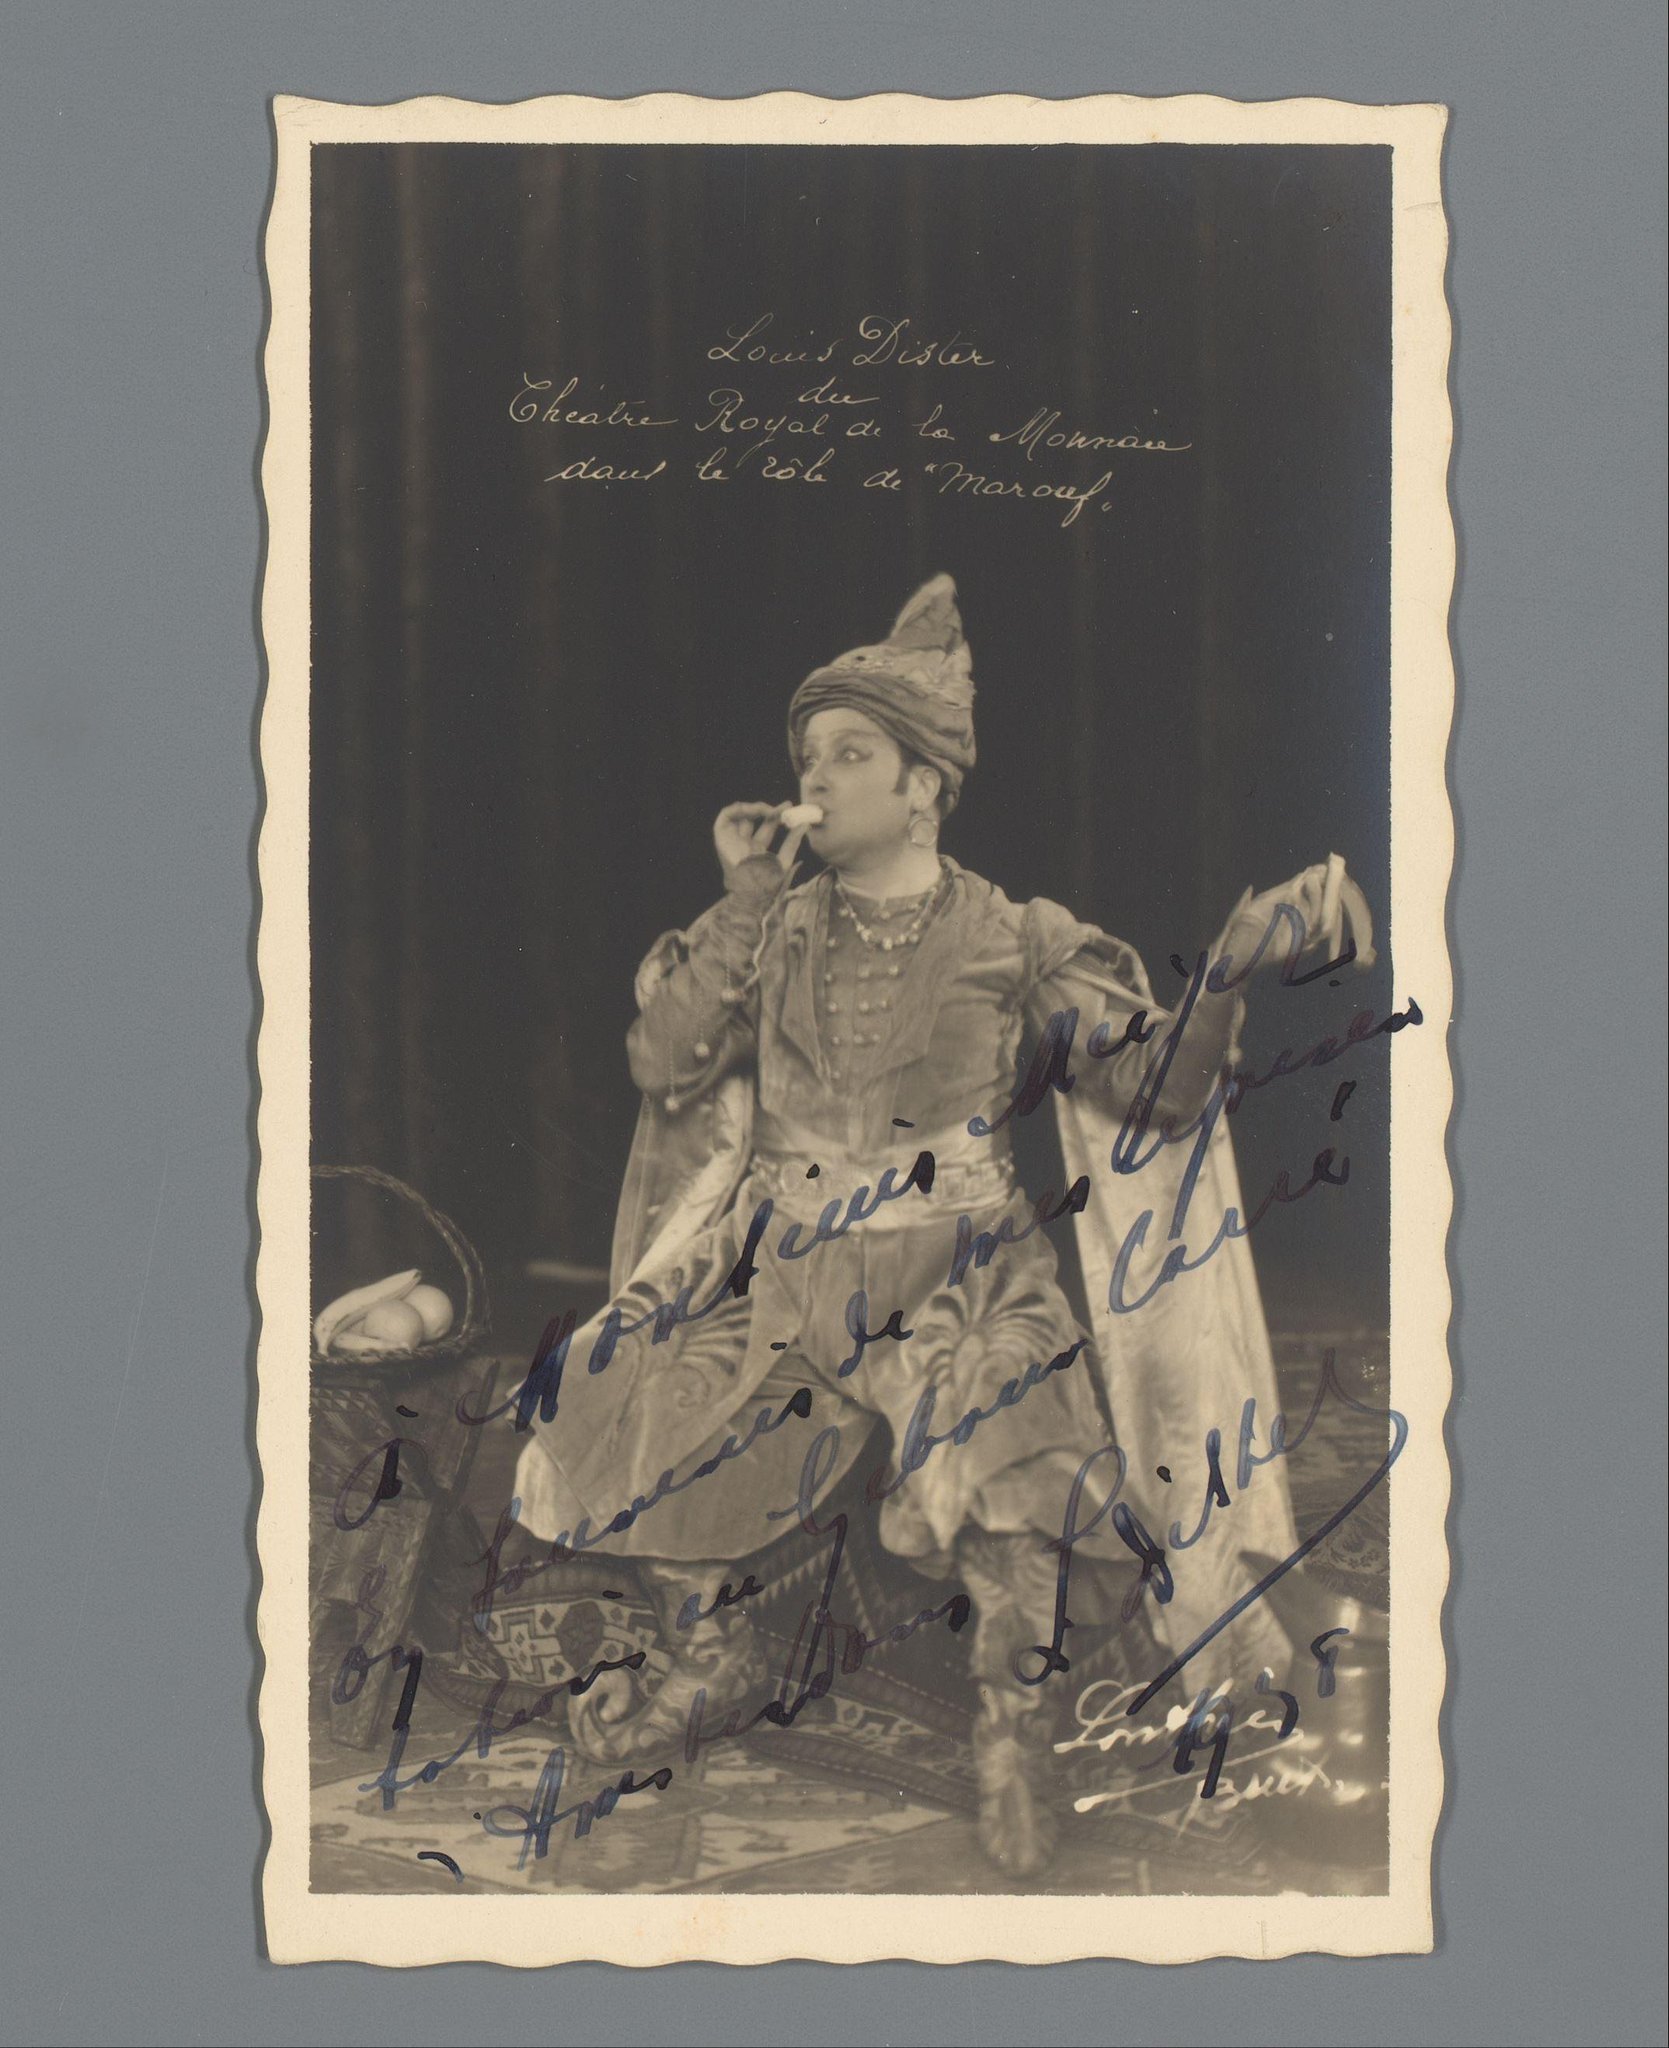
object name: photograph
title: Portret van de tenor Louis Dister, als Marouf in de opera Marouf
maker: rené lonthie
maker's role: fotograaf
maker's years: 1889-1959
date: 1938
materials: paper, ink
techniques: gelatin silver print, pen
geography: brussels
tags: liège, historical persons, portrait of opera-singer, brussels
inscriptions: stamp: ‘Commission d'Assistance Publique/ Comblain-Fairon’, inscription: ‘à Monsieur Meijer/ en souvenir de ma opéra/ Marouf au Gebouw Carré/ Amsterdam, L.Dister/ 1938’, inscription: ‘Louis Dister/ du/ Théatre Royal de la Monnaie/ dans le rôle de Marouf/ Lonthie/ Brux.’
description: Gesigneerd en met opdracht aan Nico Meijer, 1938.